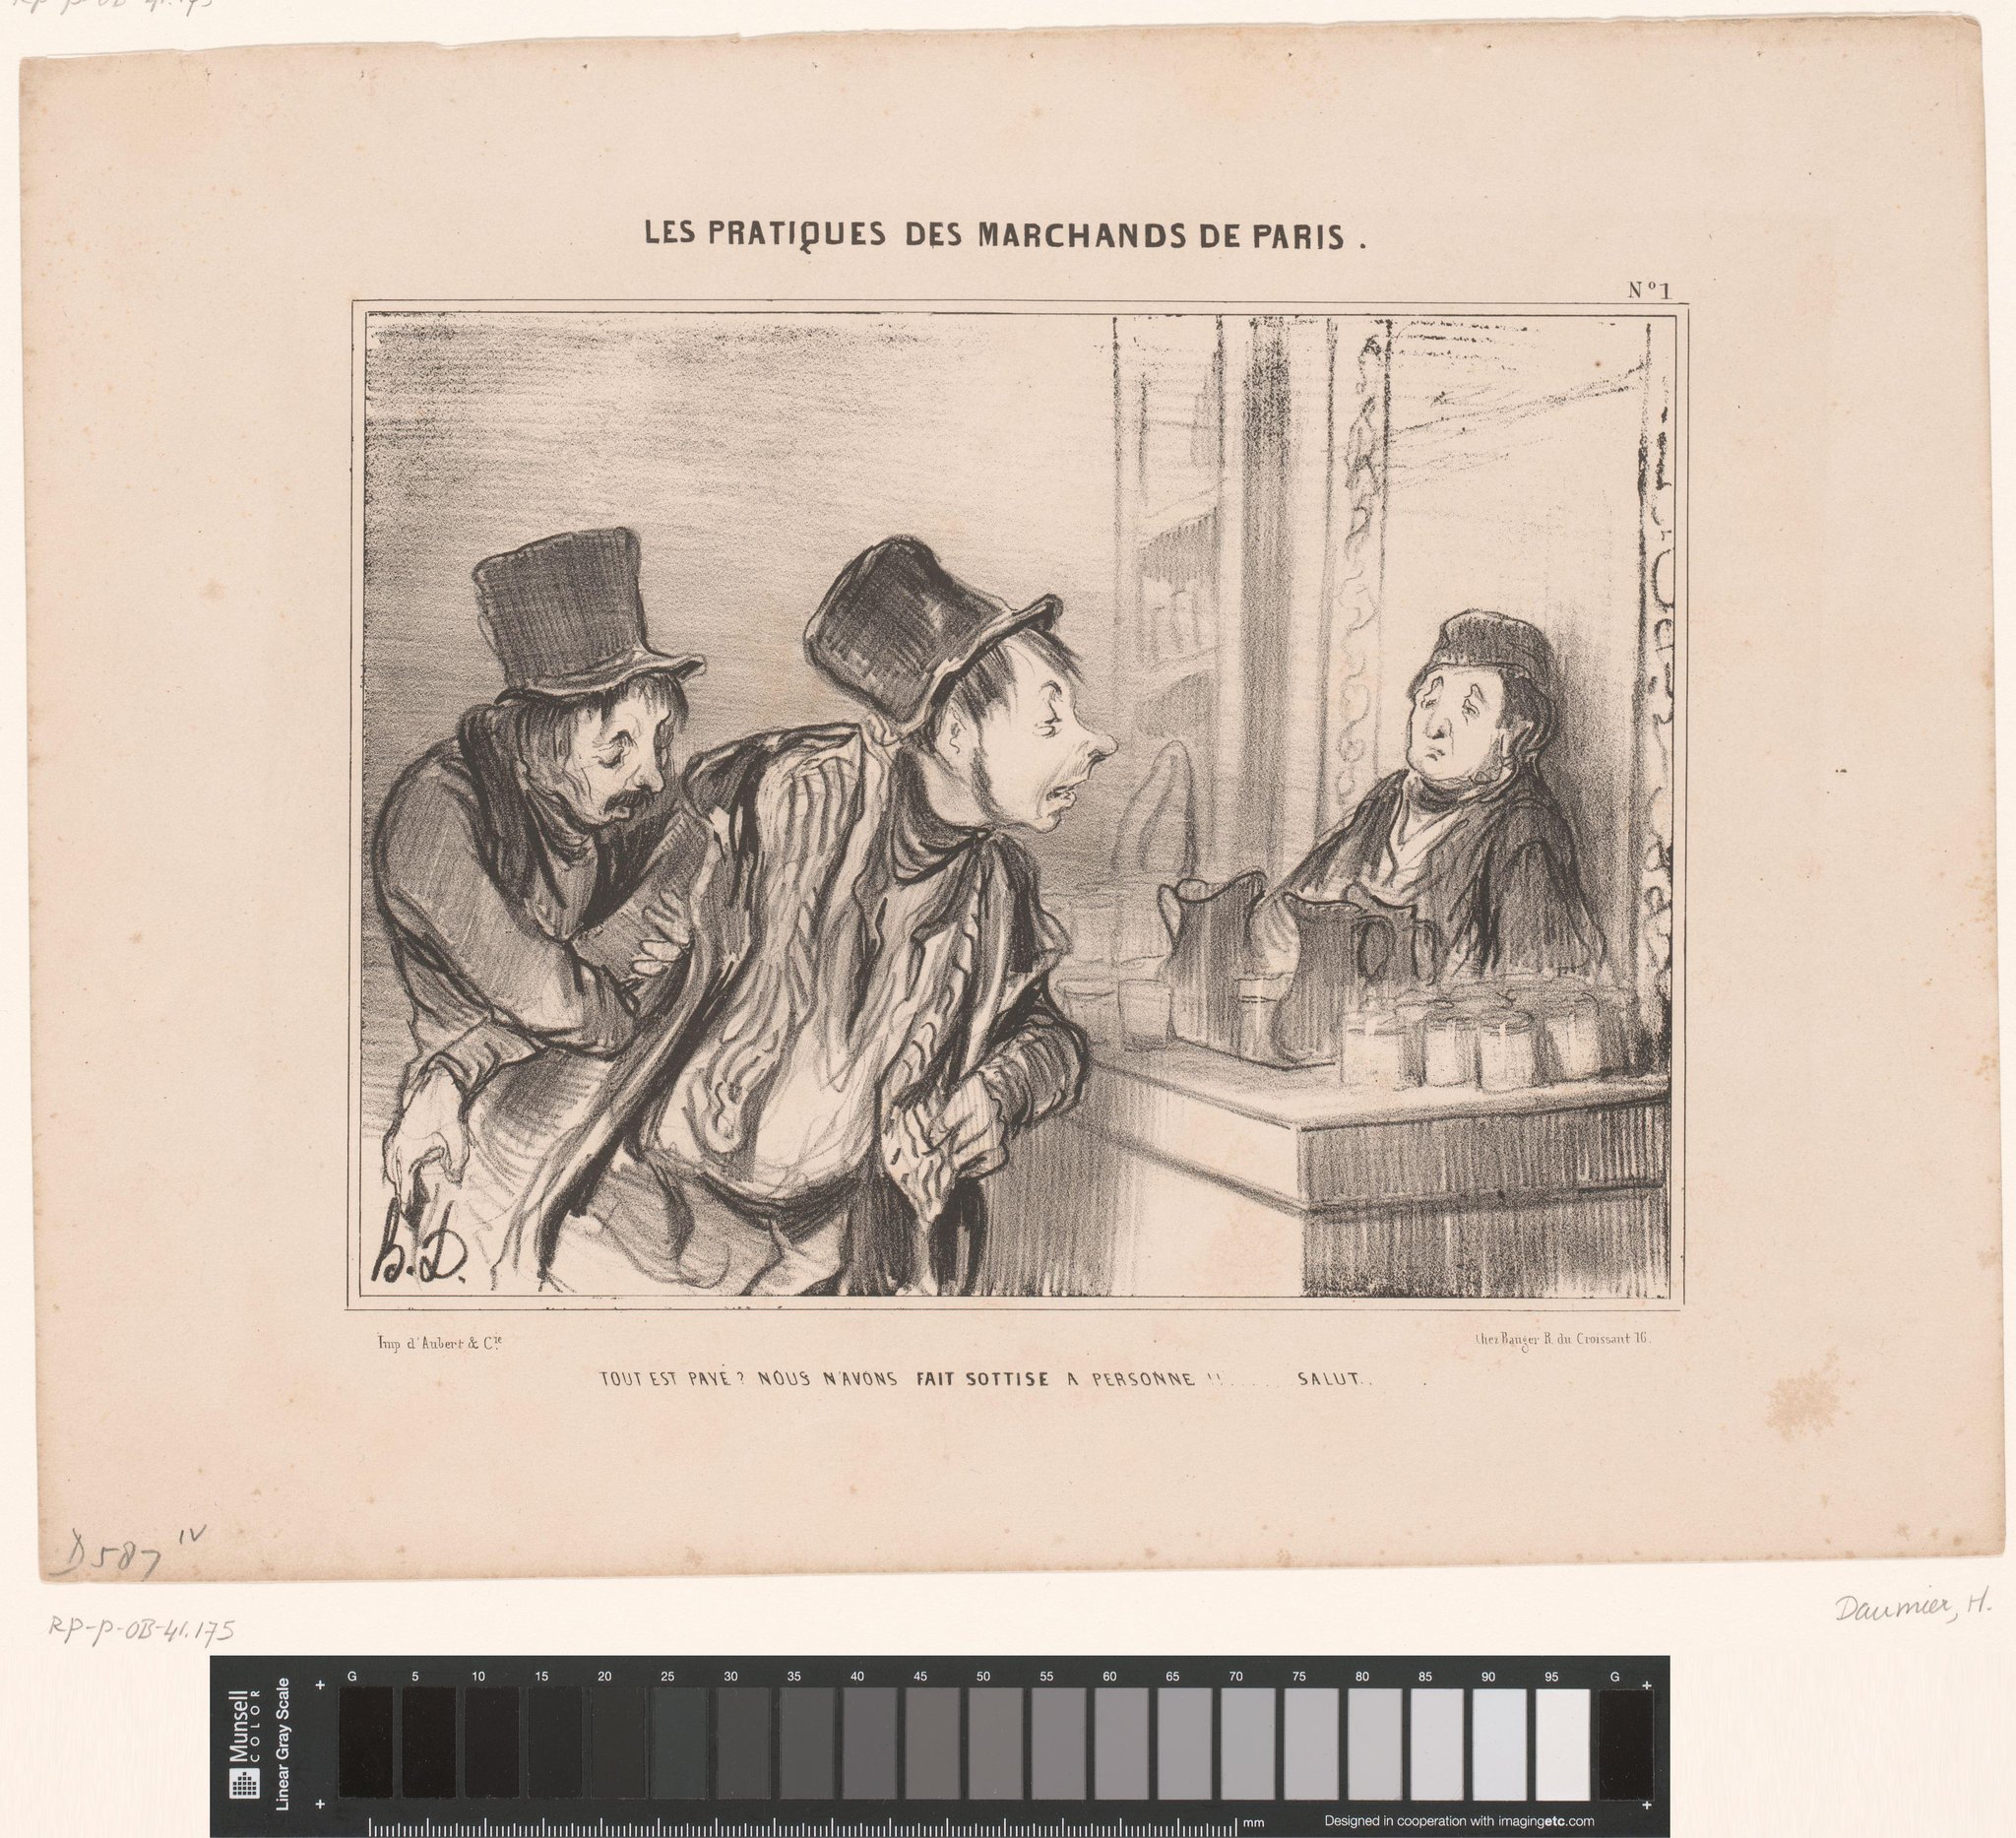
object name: cartoon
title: Tout est payé ? Nous n'avons fait sottise a personne! (...)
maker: honoré daumier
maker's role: draughtsman, painter, print maker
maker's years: 1808-1879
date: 1842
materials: paper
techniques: lithograph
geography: paris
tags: caricatures (human types), drunkard, paris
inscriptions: collector's mark: Lugt 2228a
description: Prent gebruikt voor: La Caricature nr. 14, 3 februari 1839 (eerste staat), en voor: Le Charivari, 4 juni 1842 (tweede staat). Deze (derde) staat werd in geen van beide gepubliceerd.